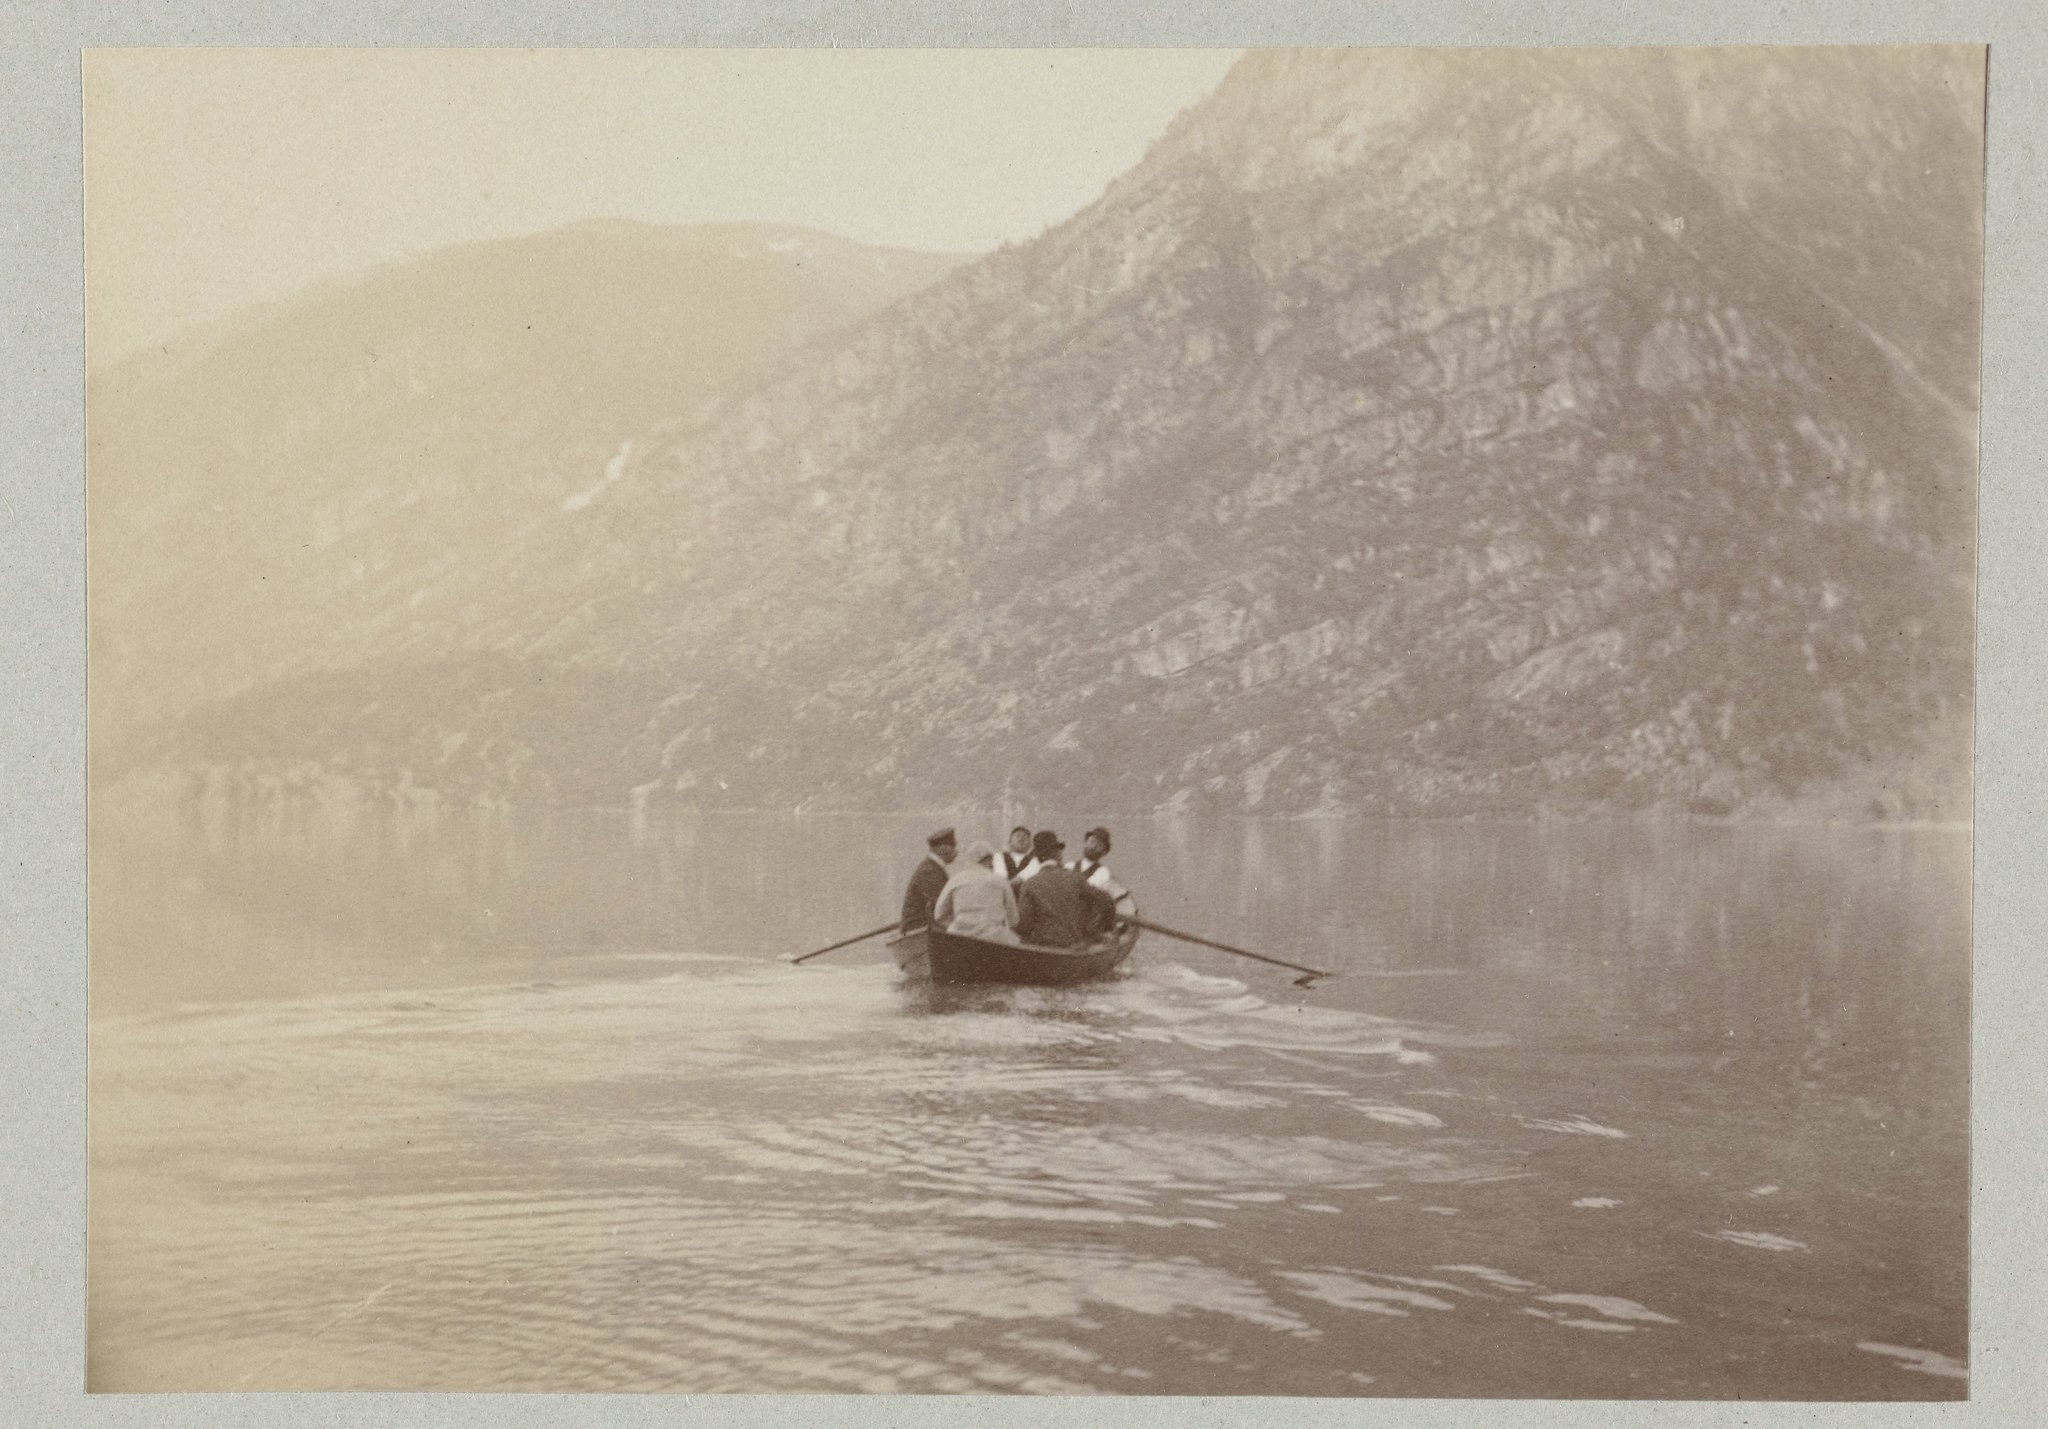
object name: photograph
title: Partie nach dem Buarbrae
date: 1807-1889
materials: cardboard, paper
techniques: albumen print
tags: wilhelm ii (keizer van duitsland), norway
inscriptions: number: ‘6’